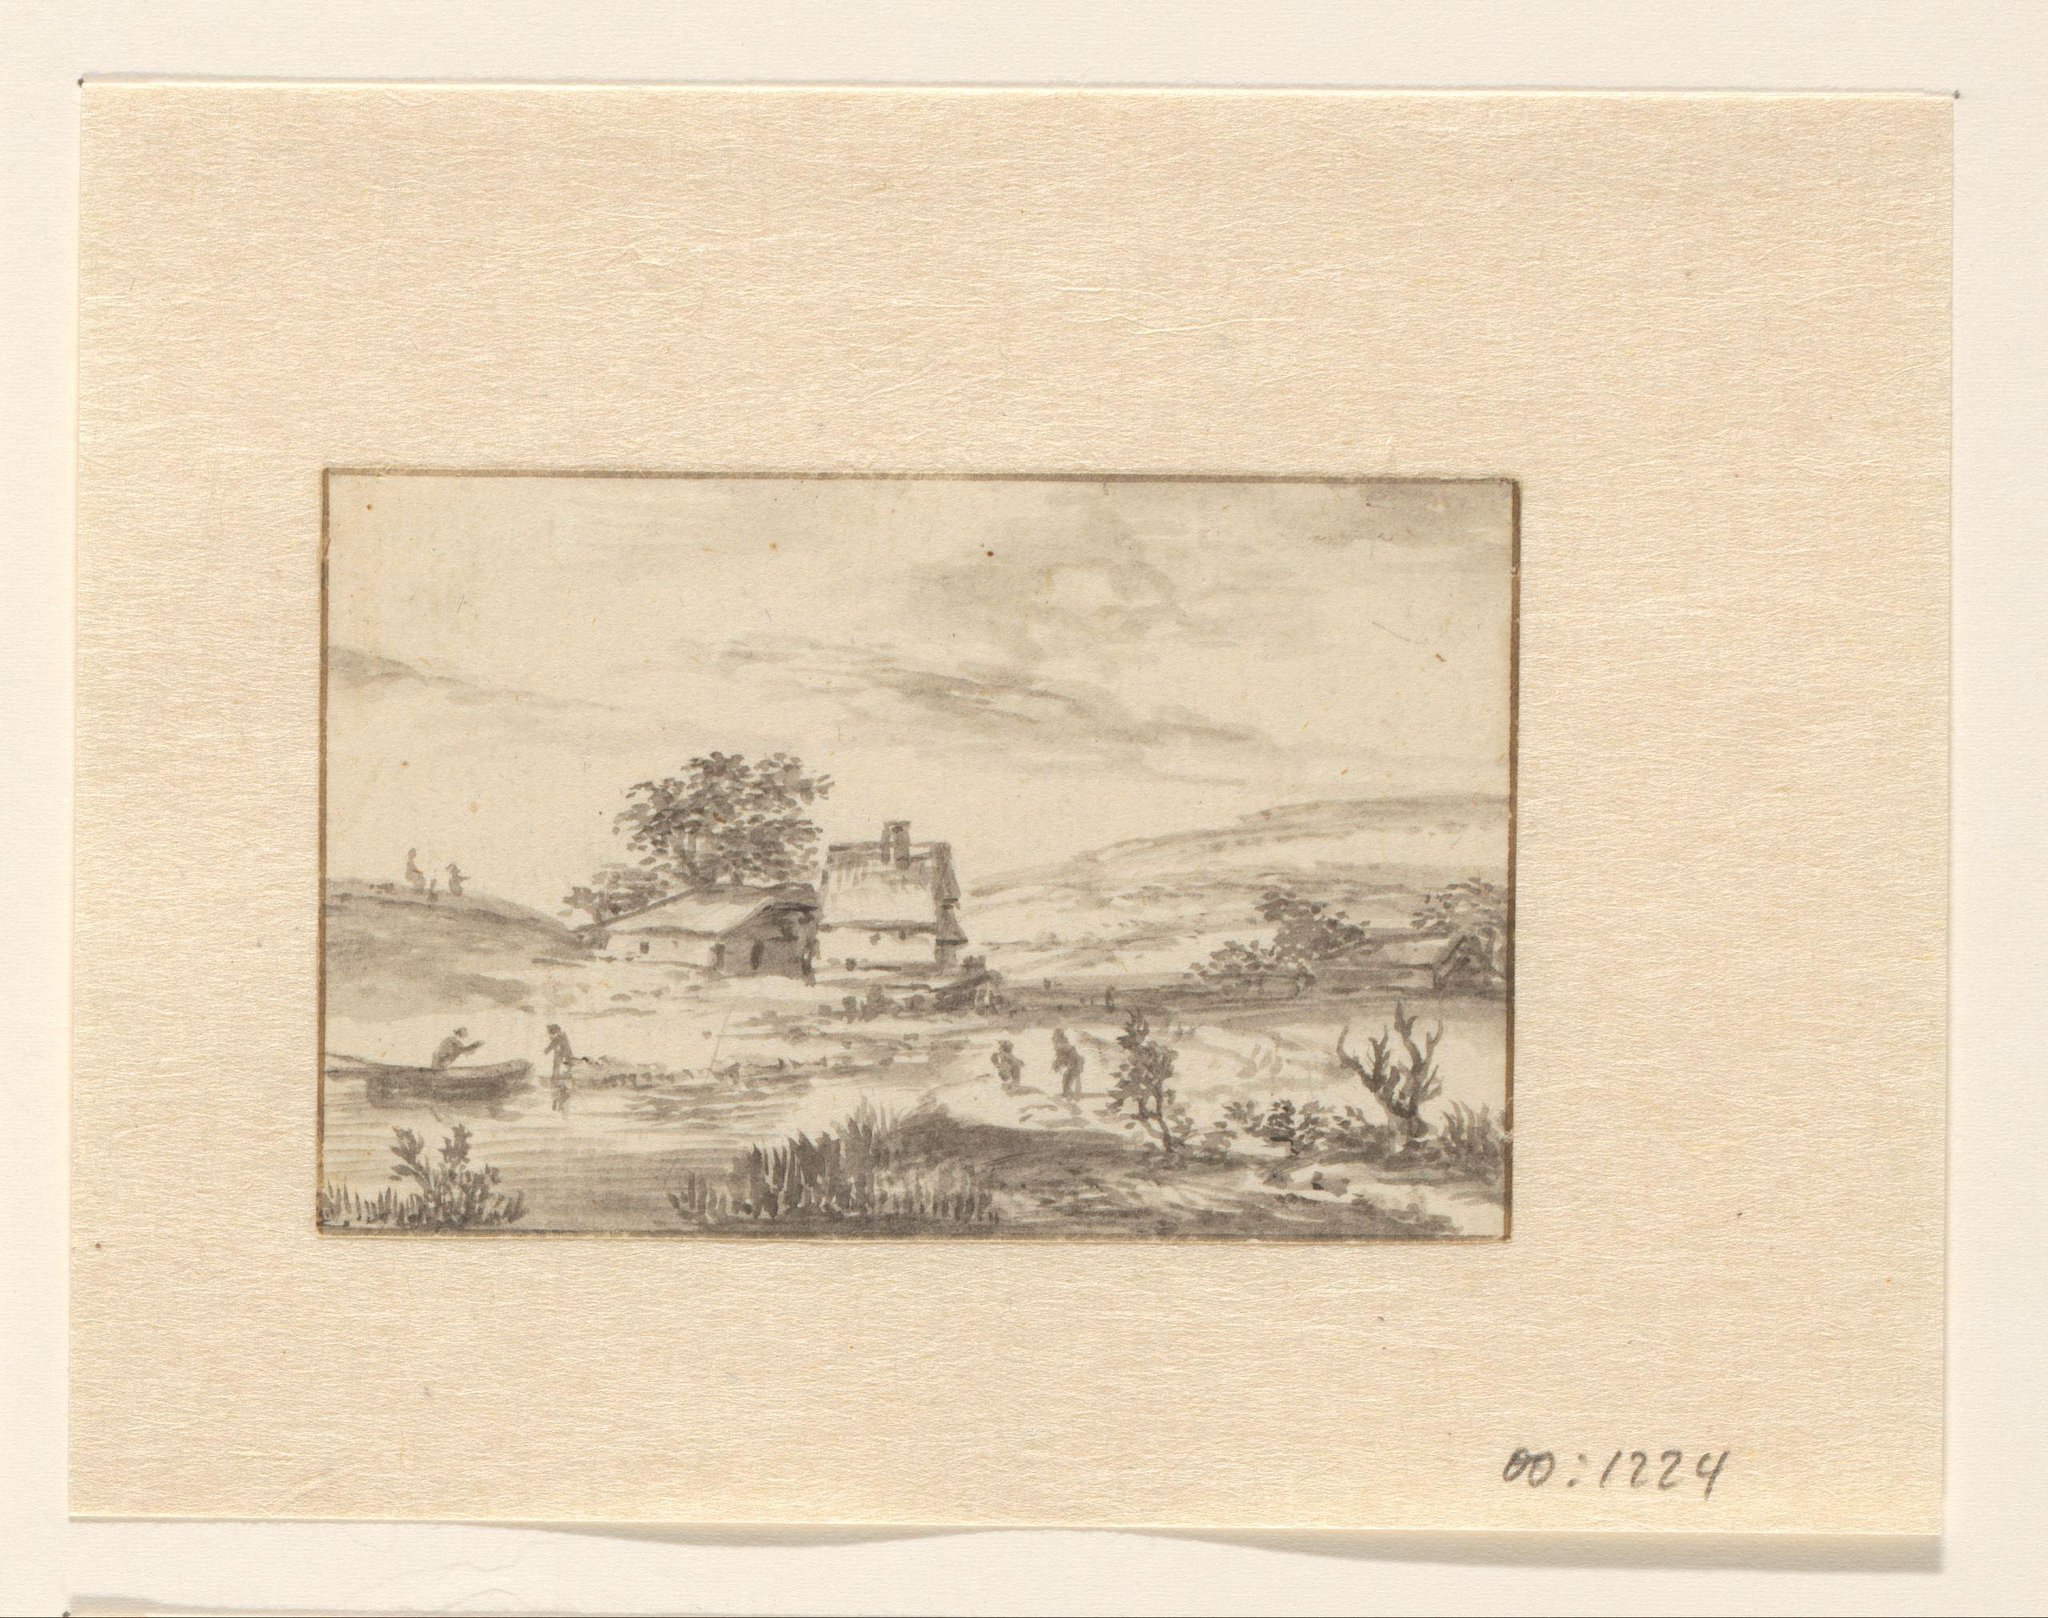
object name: drawing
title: Landschap met boerderij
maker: valentijn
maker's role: draughtsman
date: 1700-1800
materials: ink, paper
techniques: brush, pen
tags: farm or solitary house in landscape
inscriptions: inscription: ‘Valentijn 2’